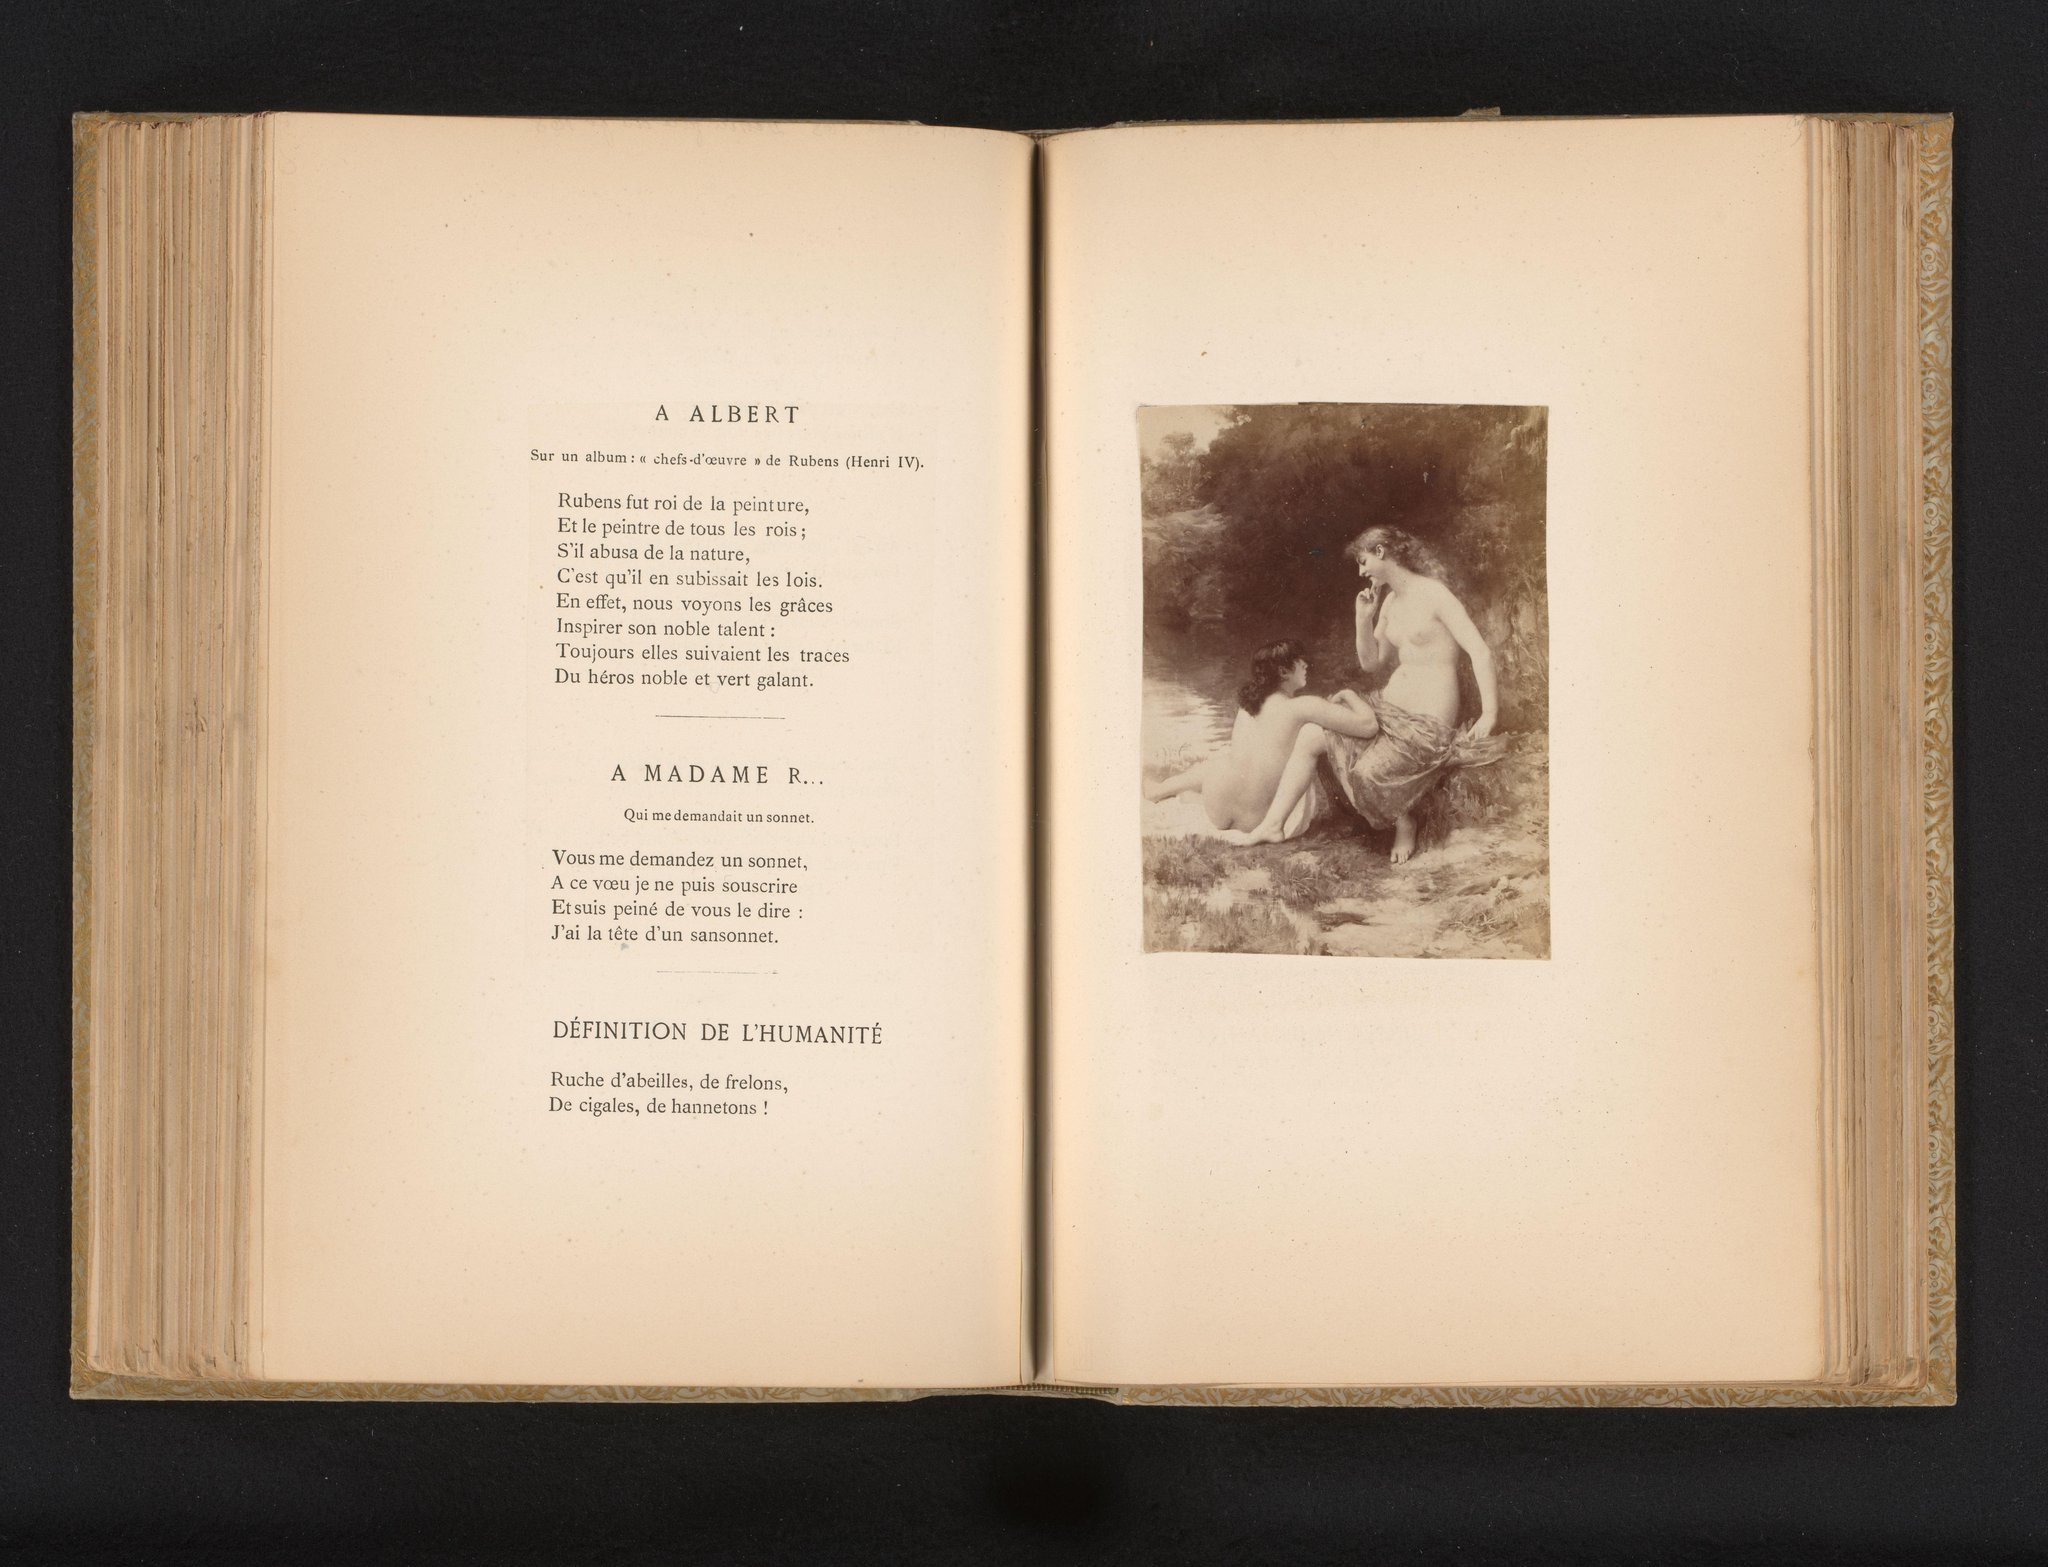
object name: photograph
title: Fotoreproductie van een schilderij van twee badende vrouwen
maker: Anonymous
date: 1874-1884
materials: paper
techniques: albumen print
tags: taking a bath - aa - in the open air, adult woman (+ two persons), picture, painting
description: Foto op tweede ongenummerde pagina na pagina 167.